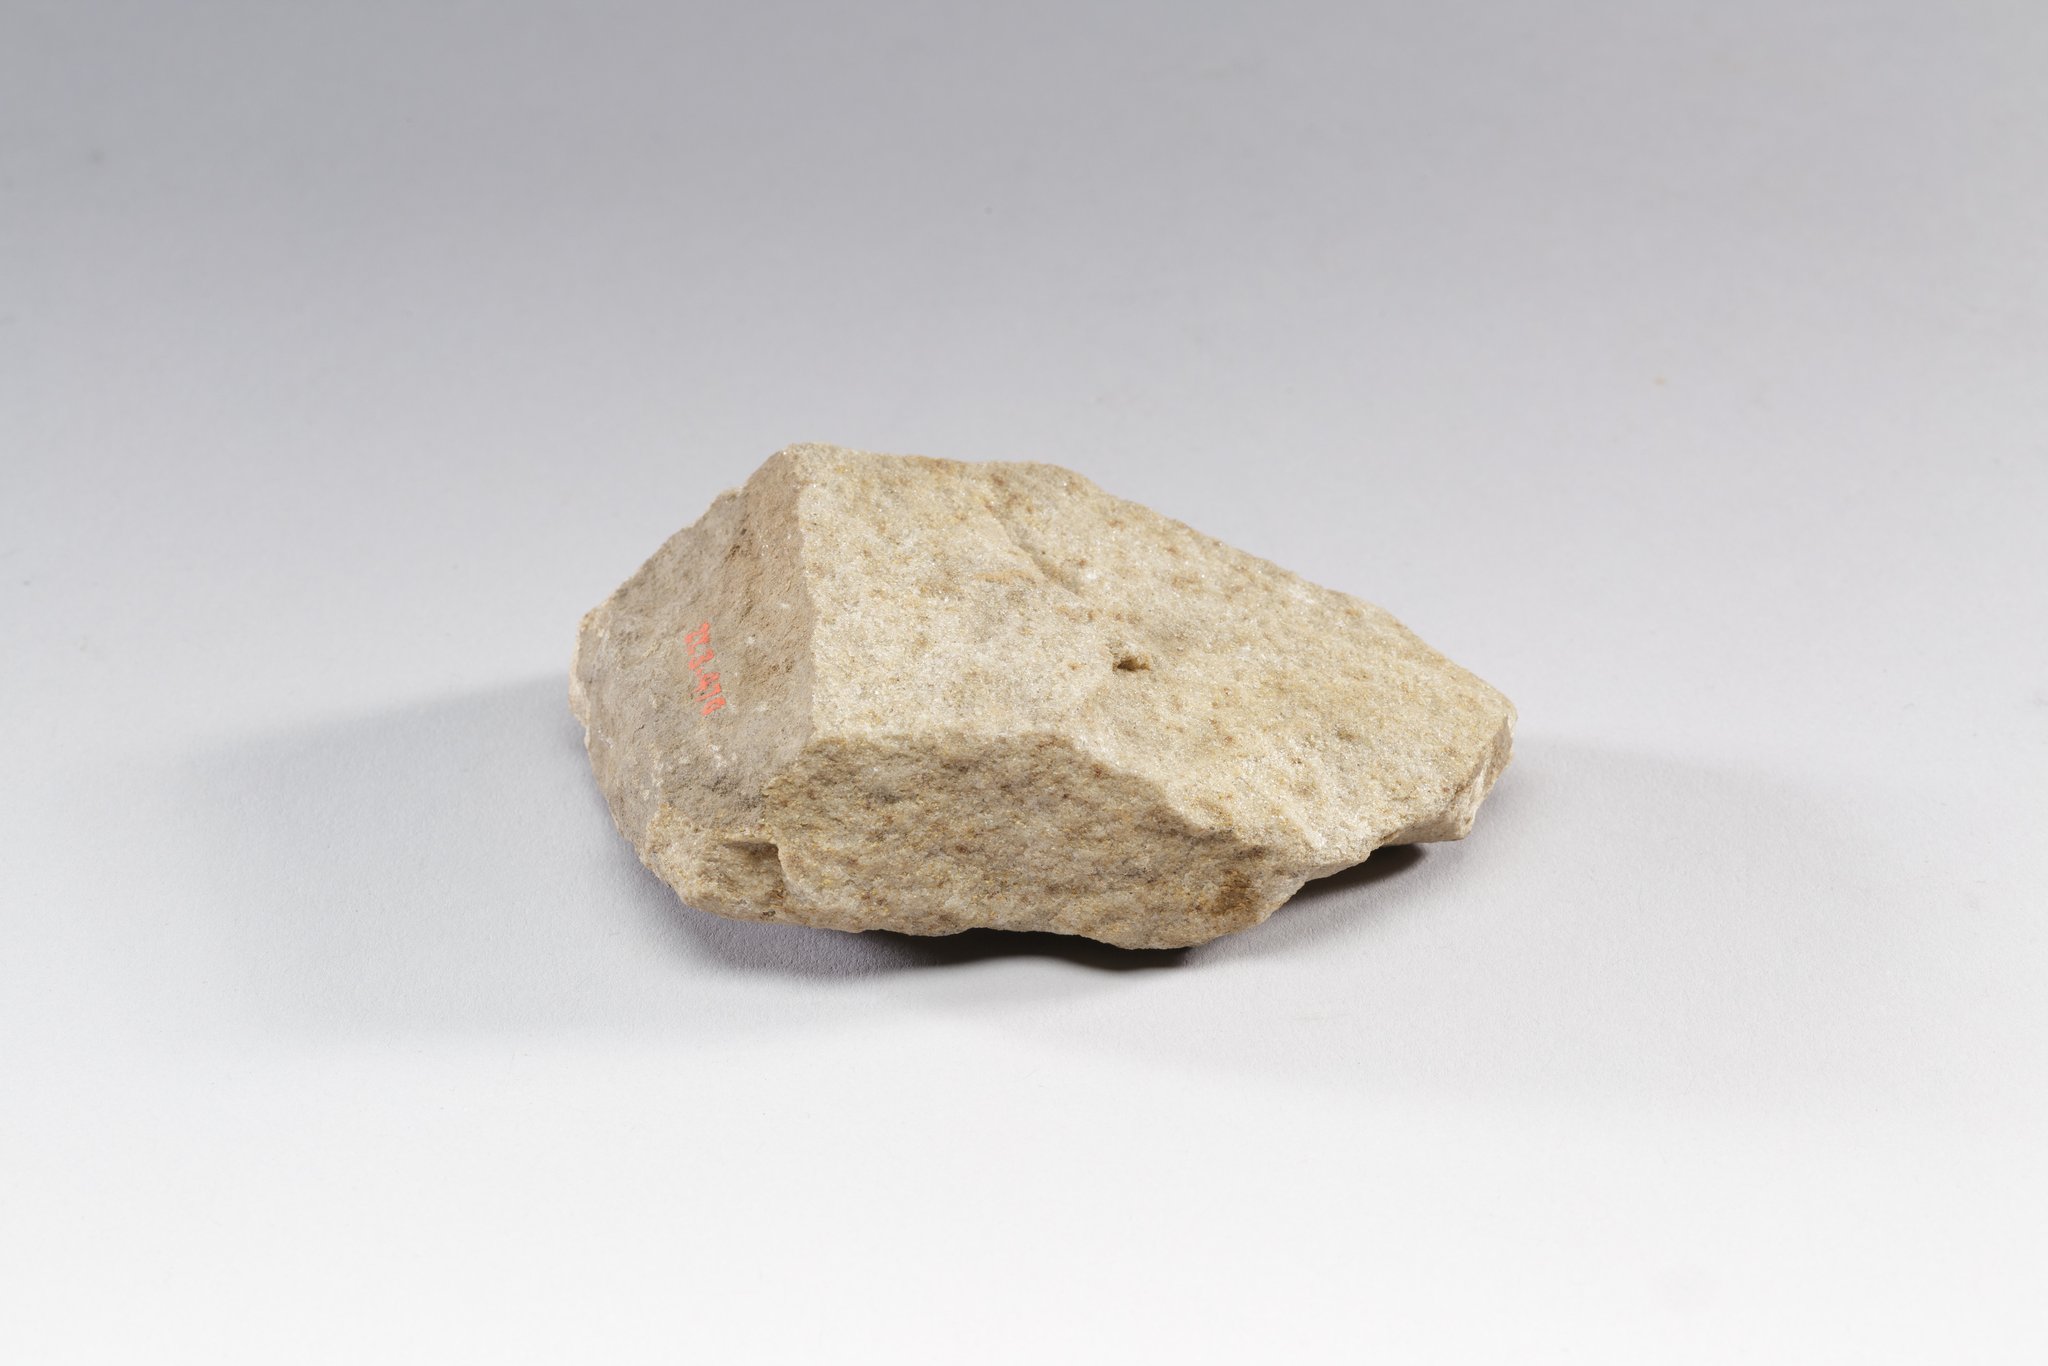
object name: rubbing stone, tool, senenmut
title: Rubbing Stone (?)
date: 1479-1458 BCE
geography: egypt